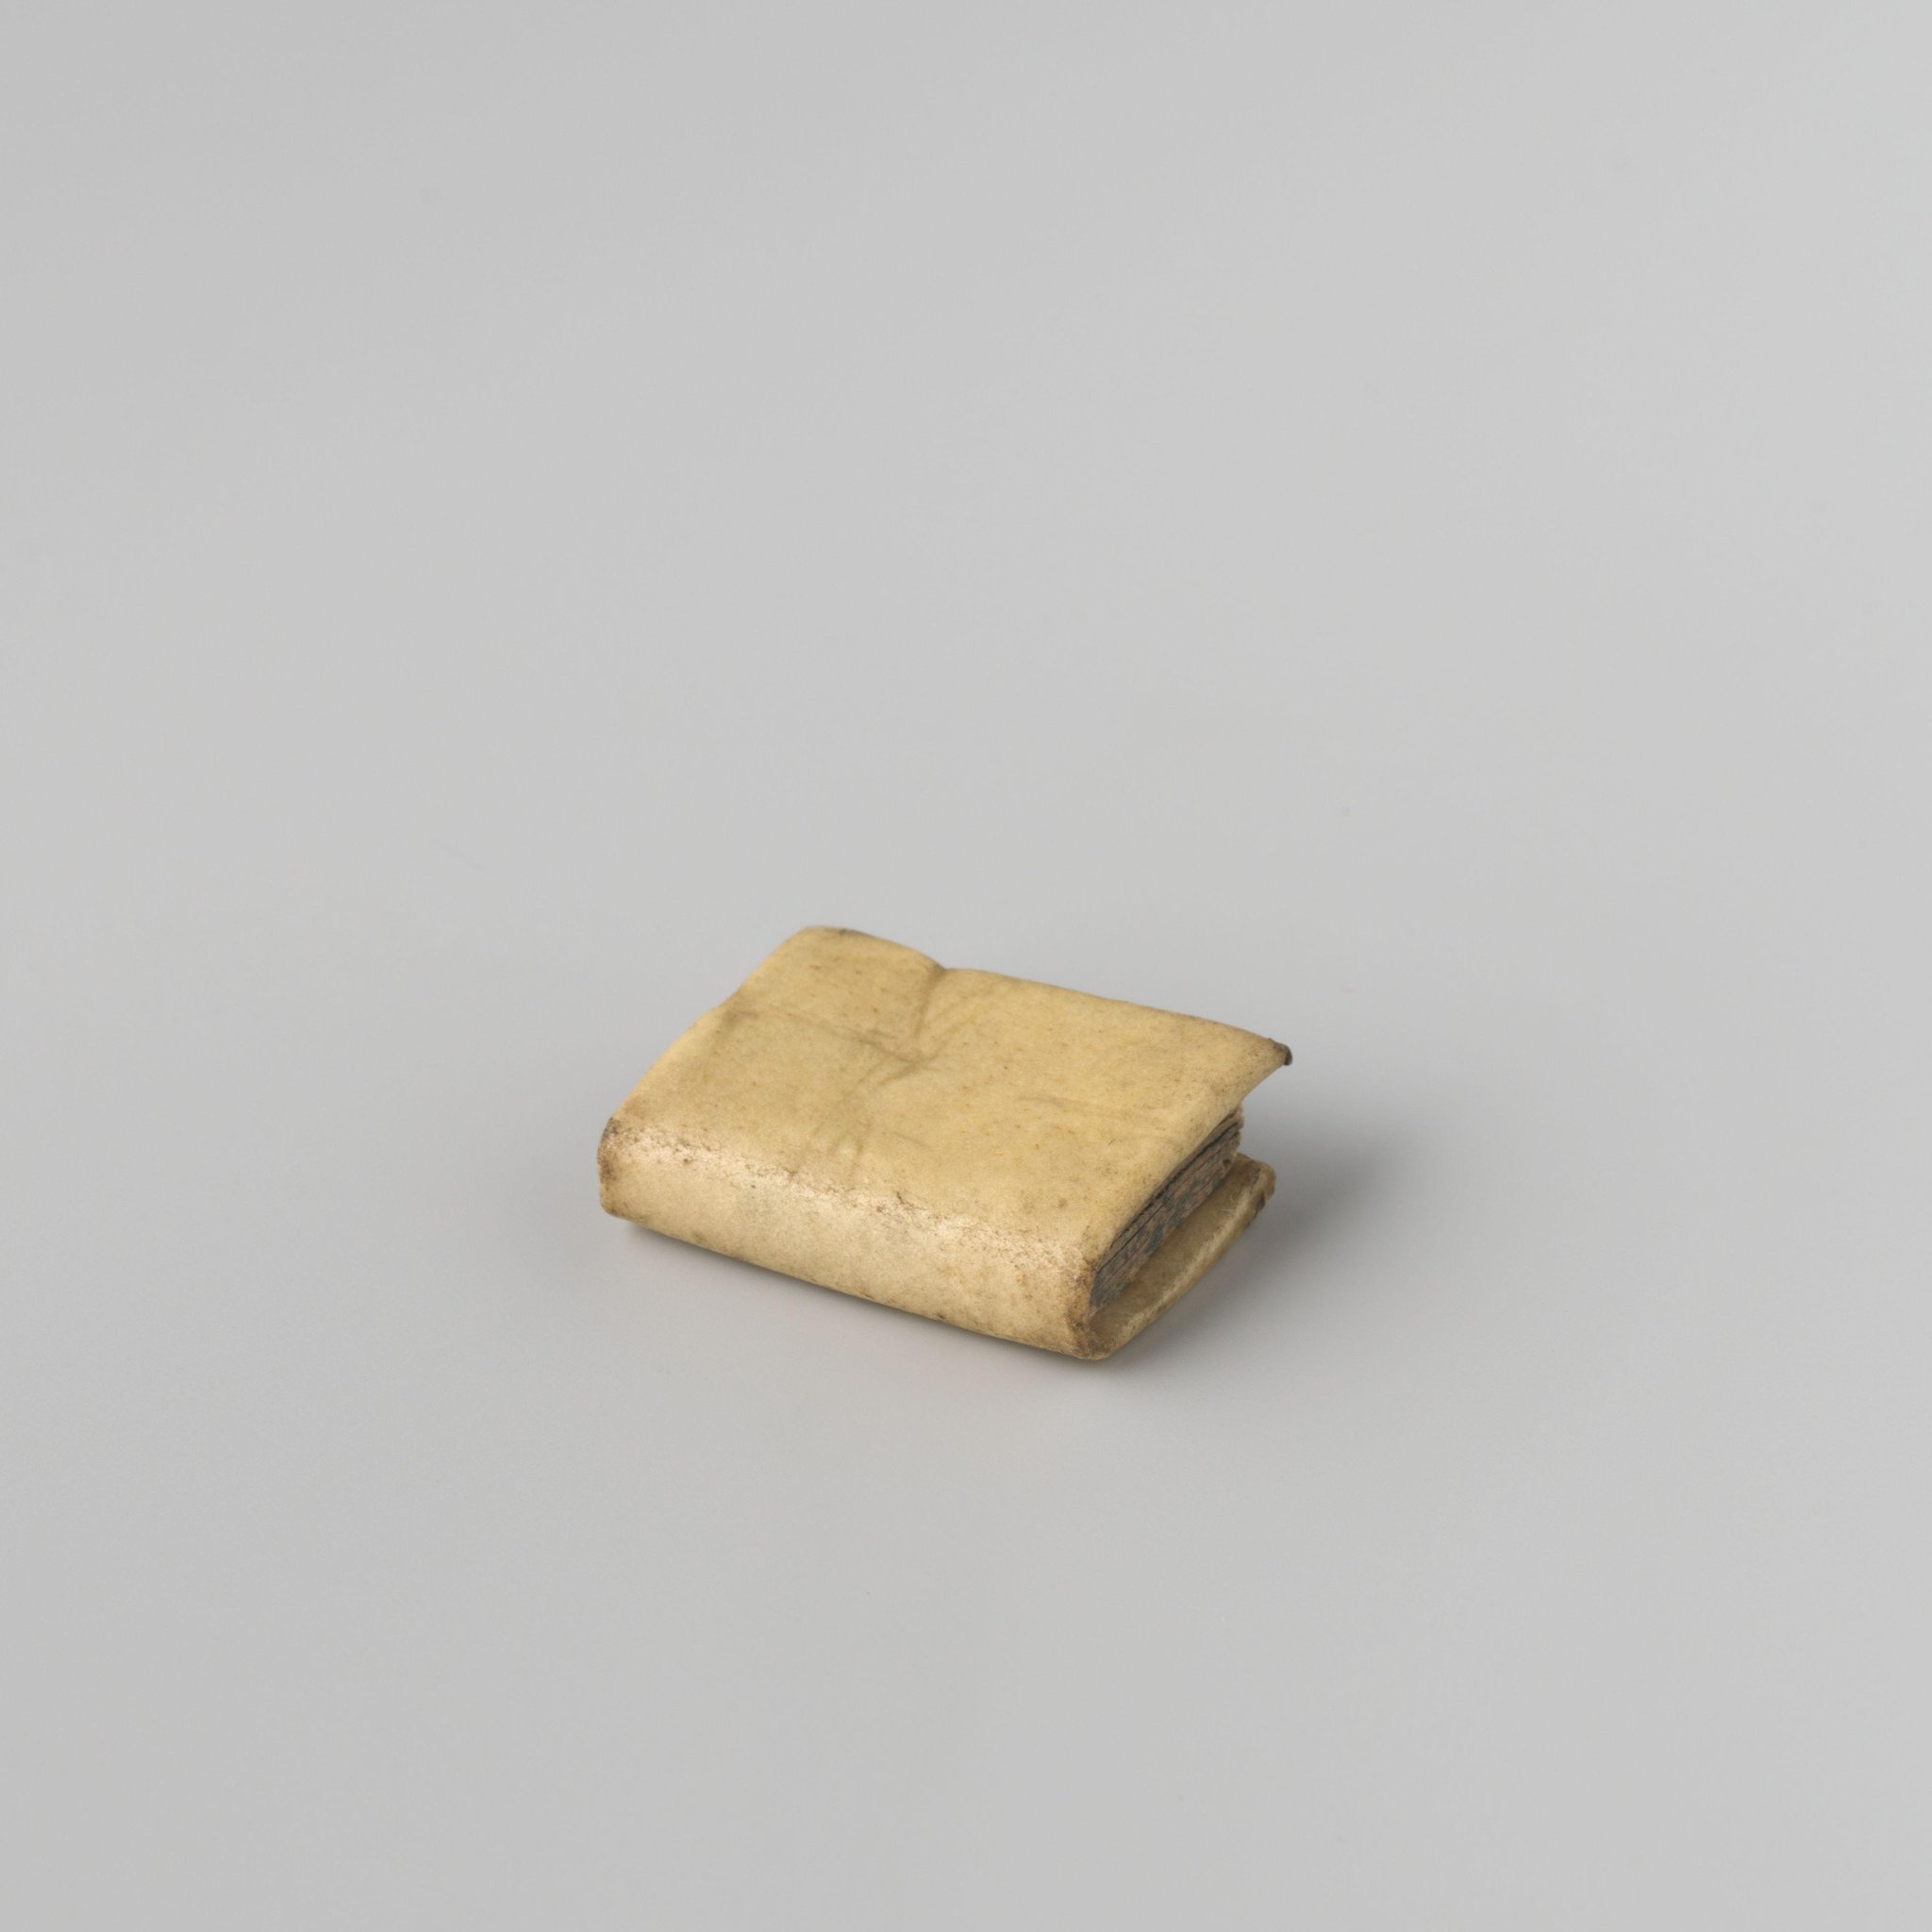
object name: book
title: Boek met figuren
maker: Anonymous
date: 1690-1710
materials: paper, parchment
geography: amsterdam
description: Boek met figuren. Ingebonden in blank perkament.